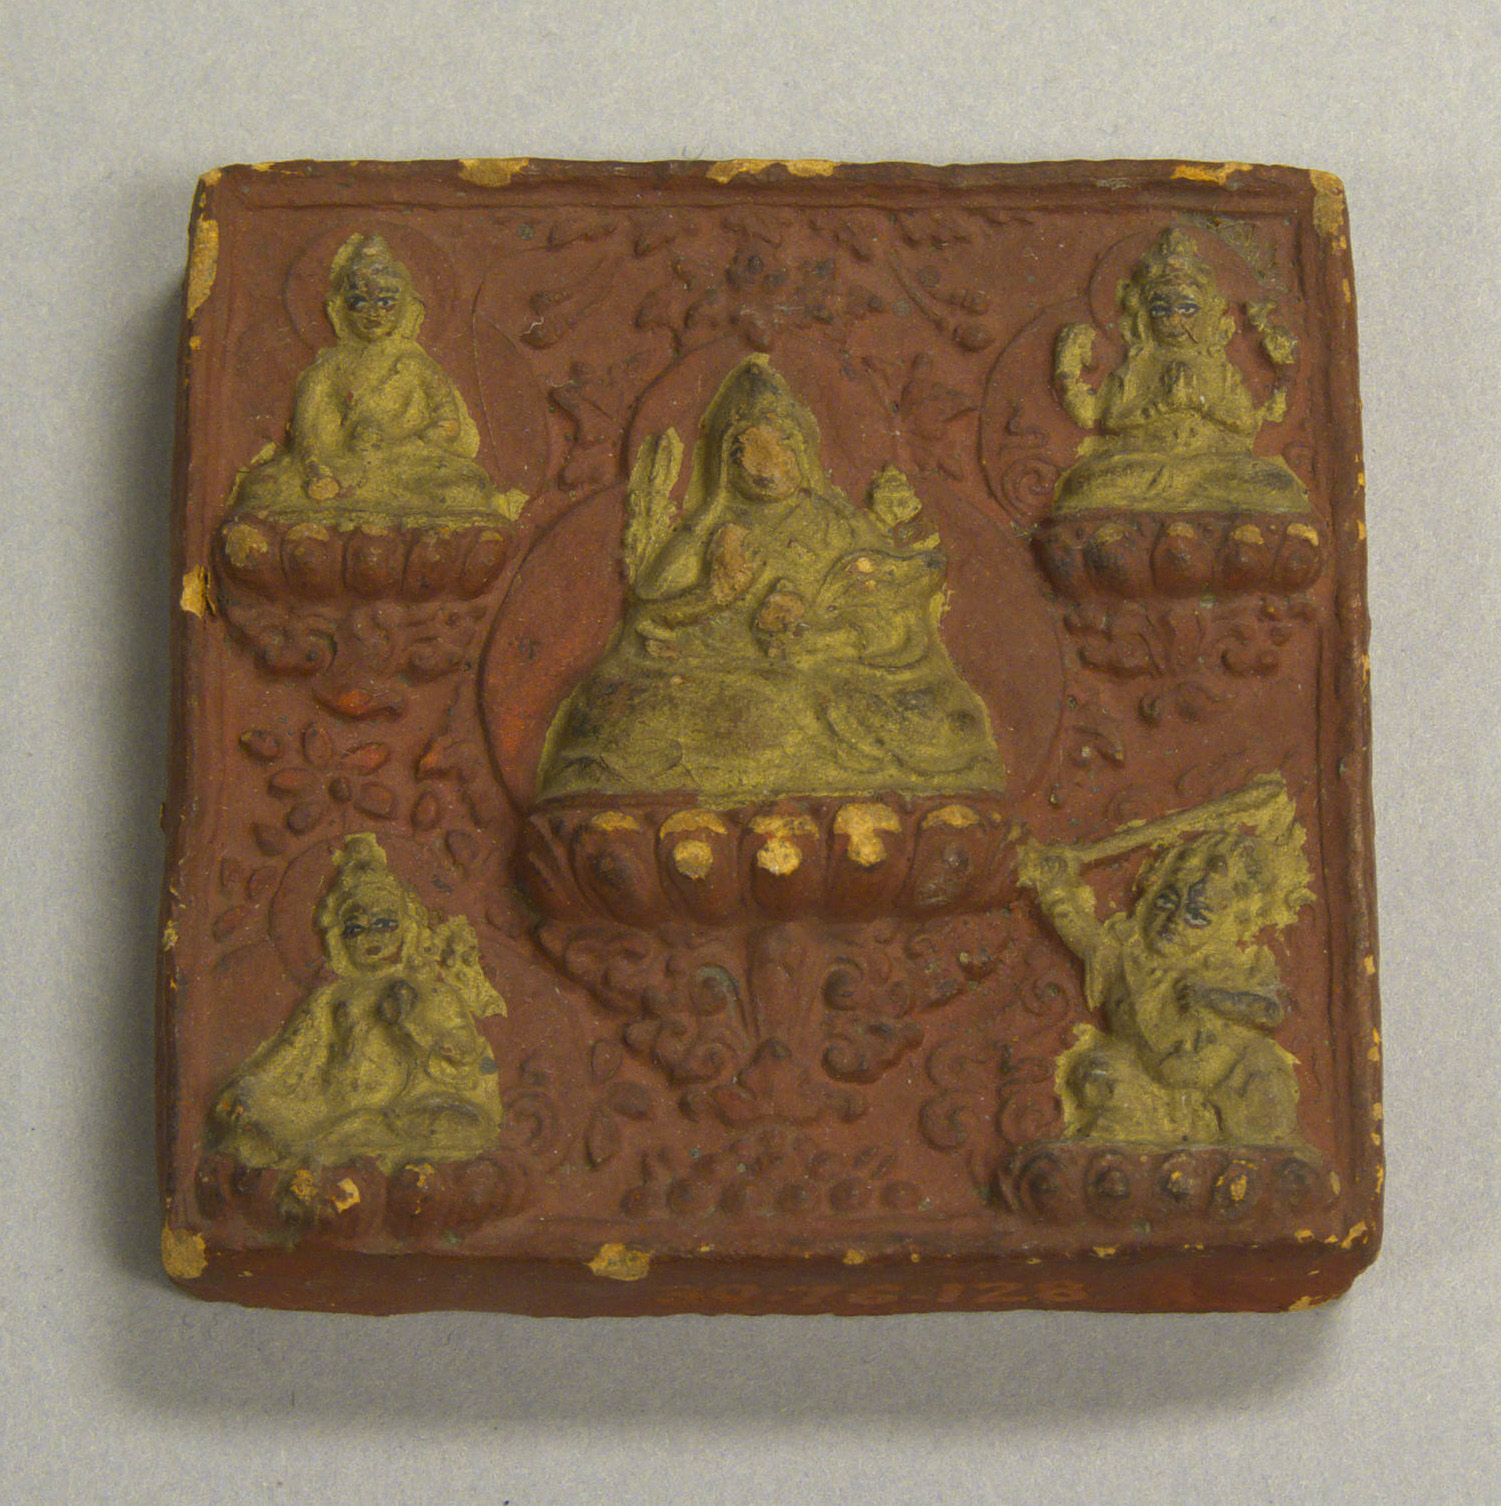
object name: votive tablet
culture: chinese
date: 1368-1644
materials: pottery